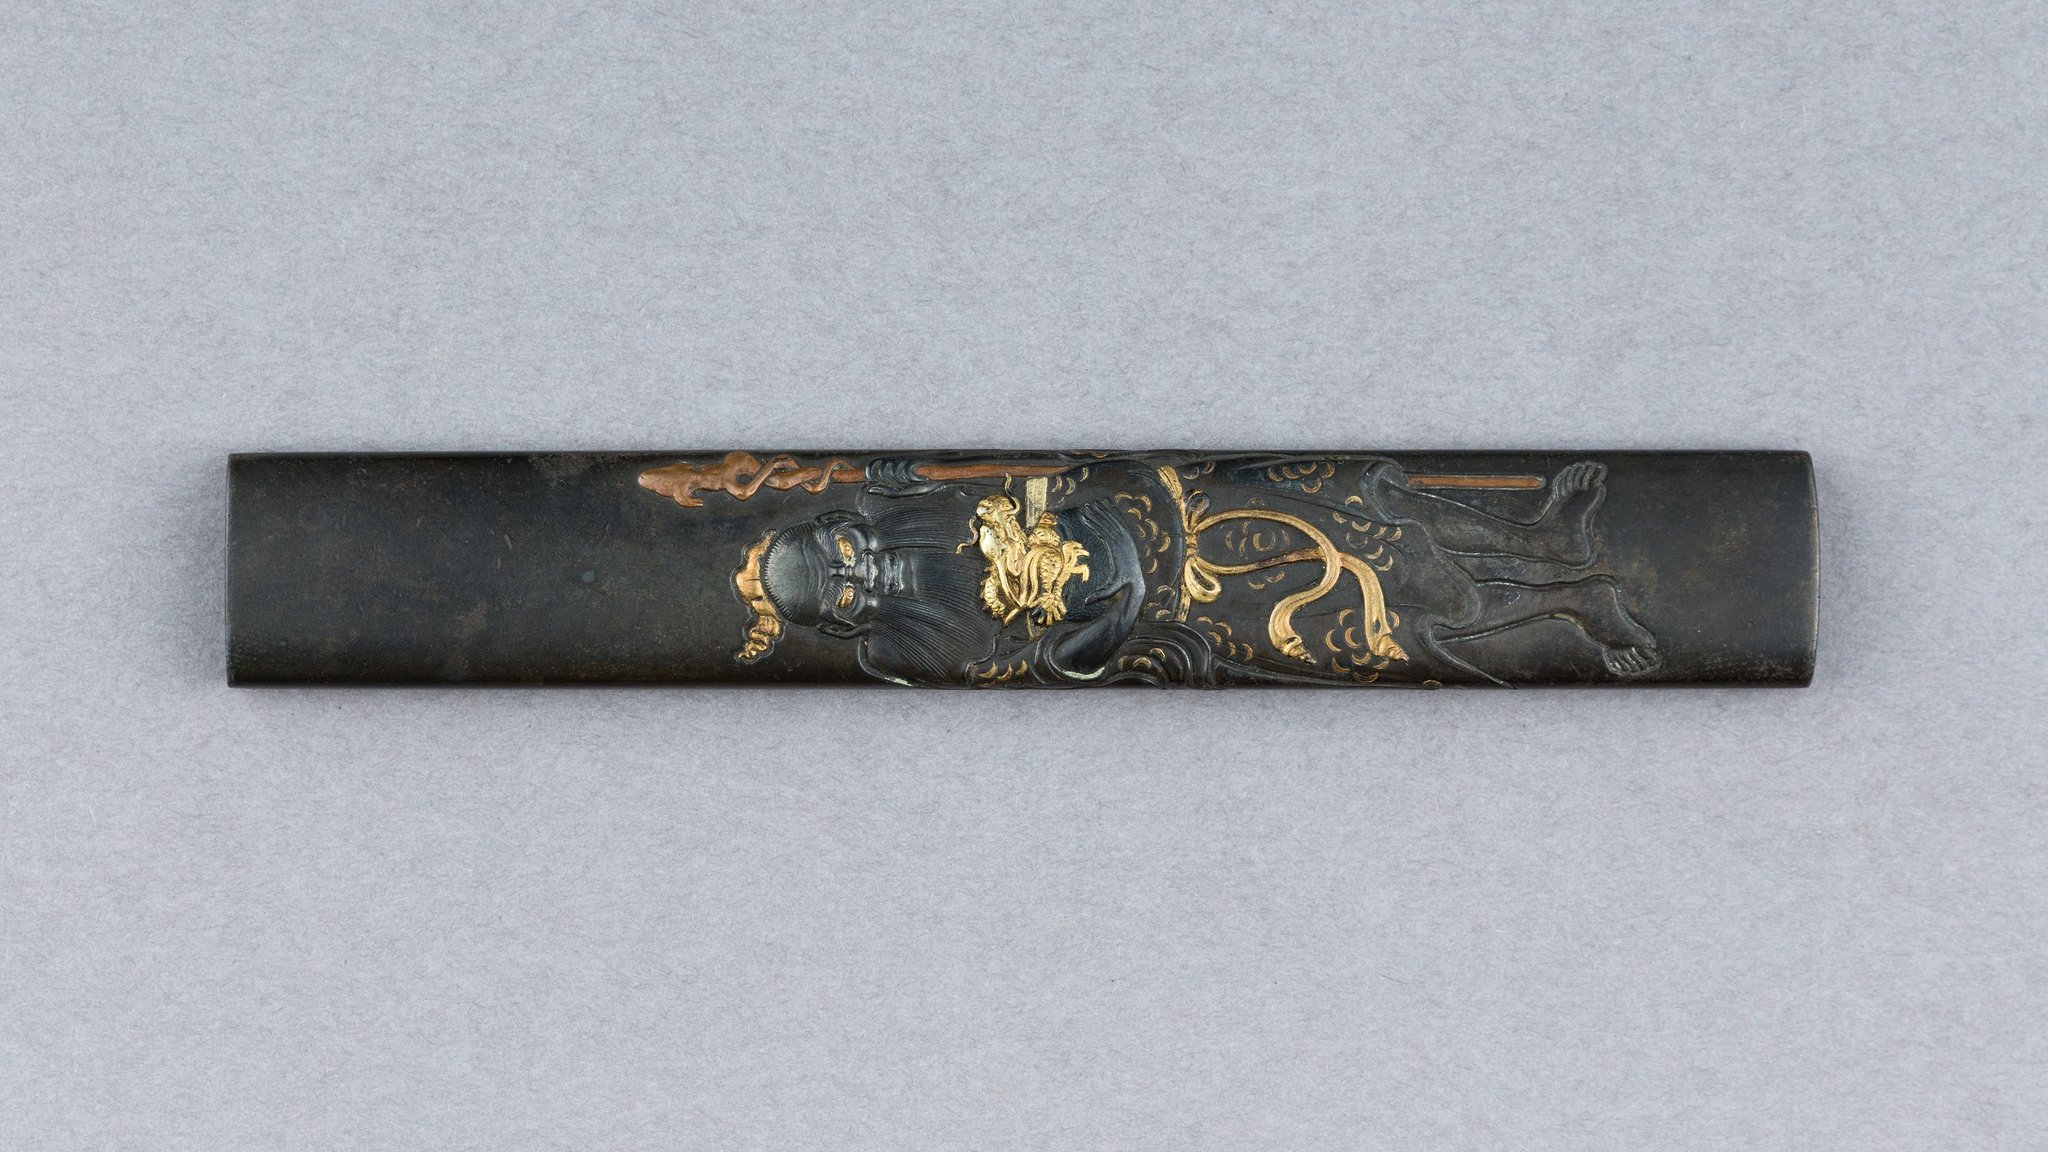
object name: knife handle kozuka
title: Knife Handle (Kozuka)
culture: japanese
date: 1701-1800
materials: copper, gold alloy, gold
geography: japan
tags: men